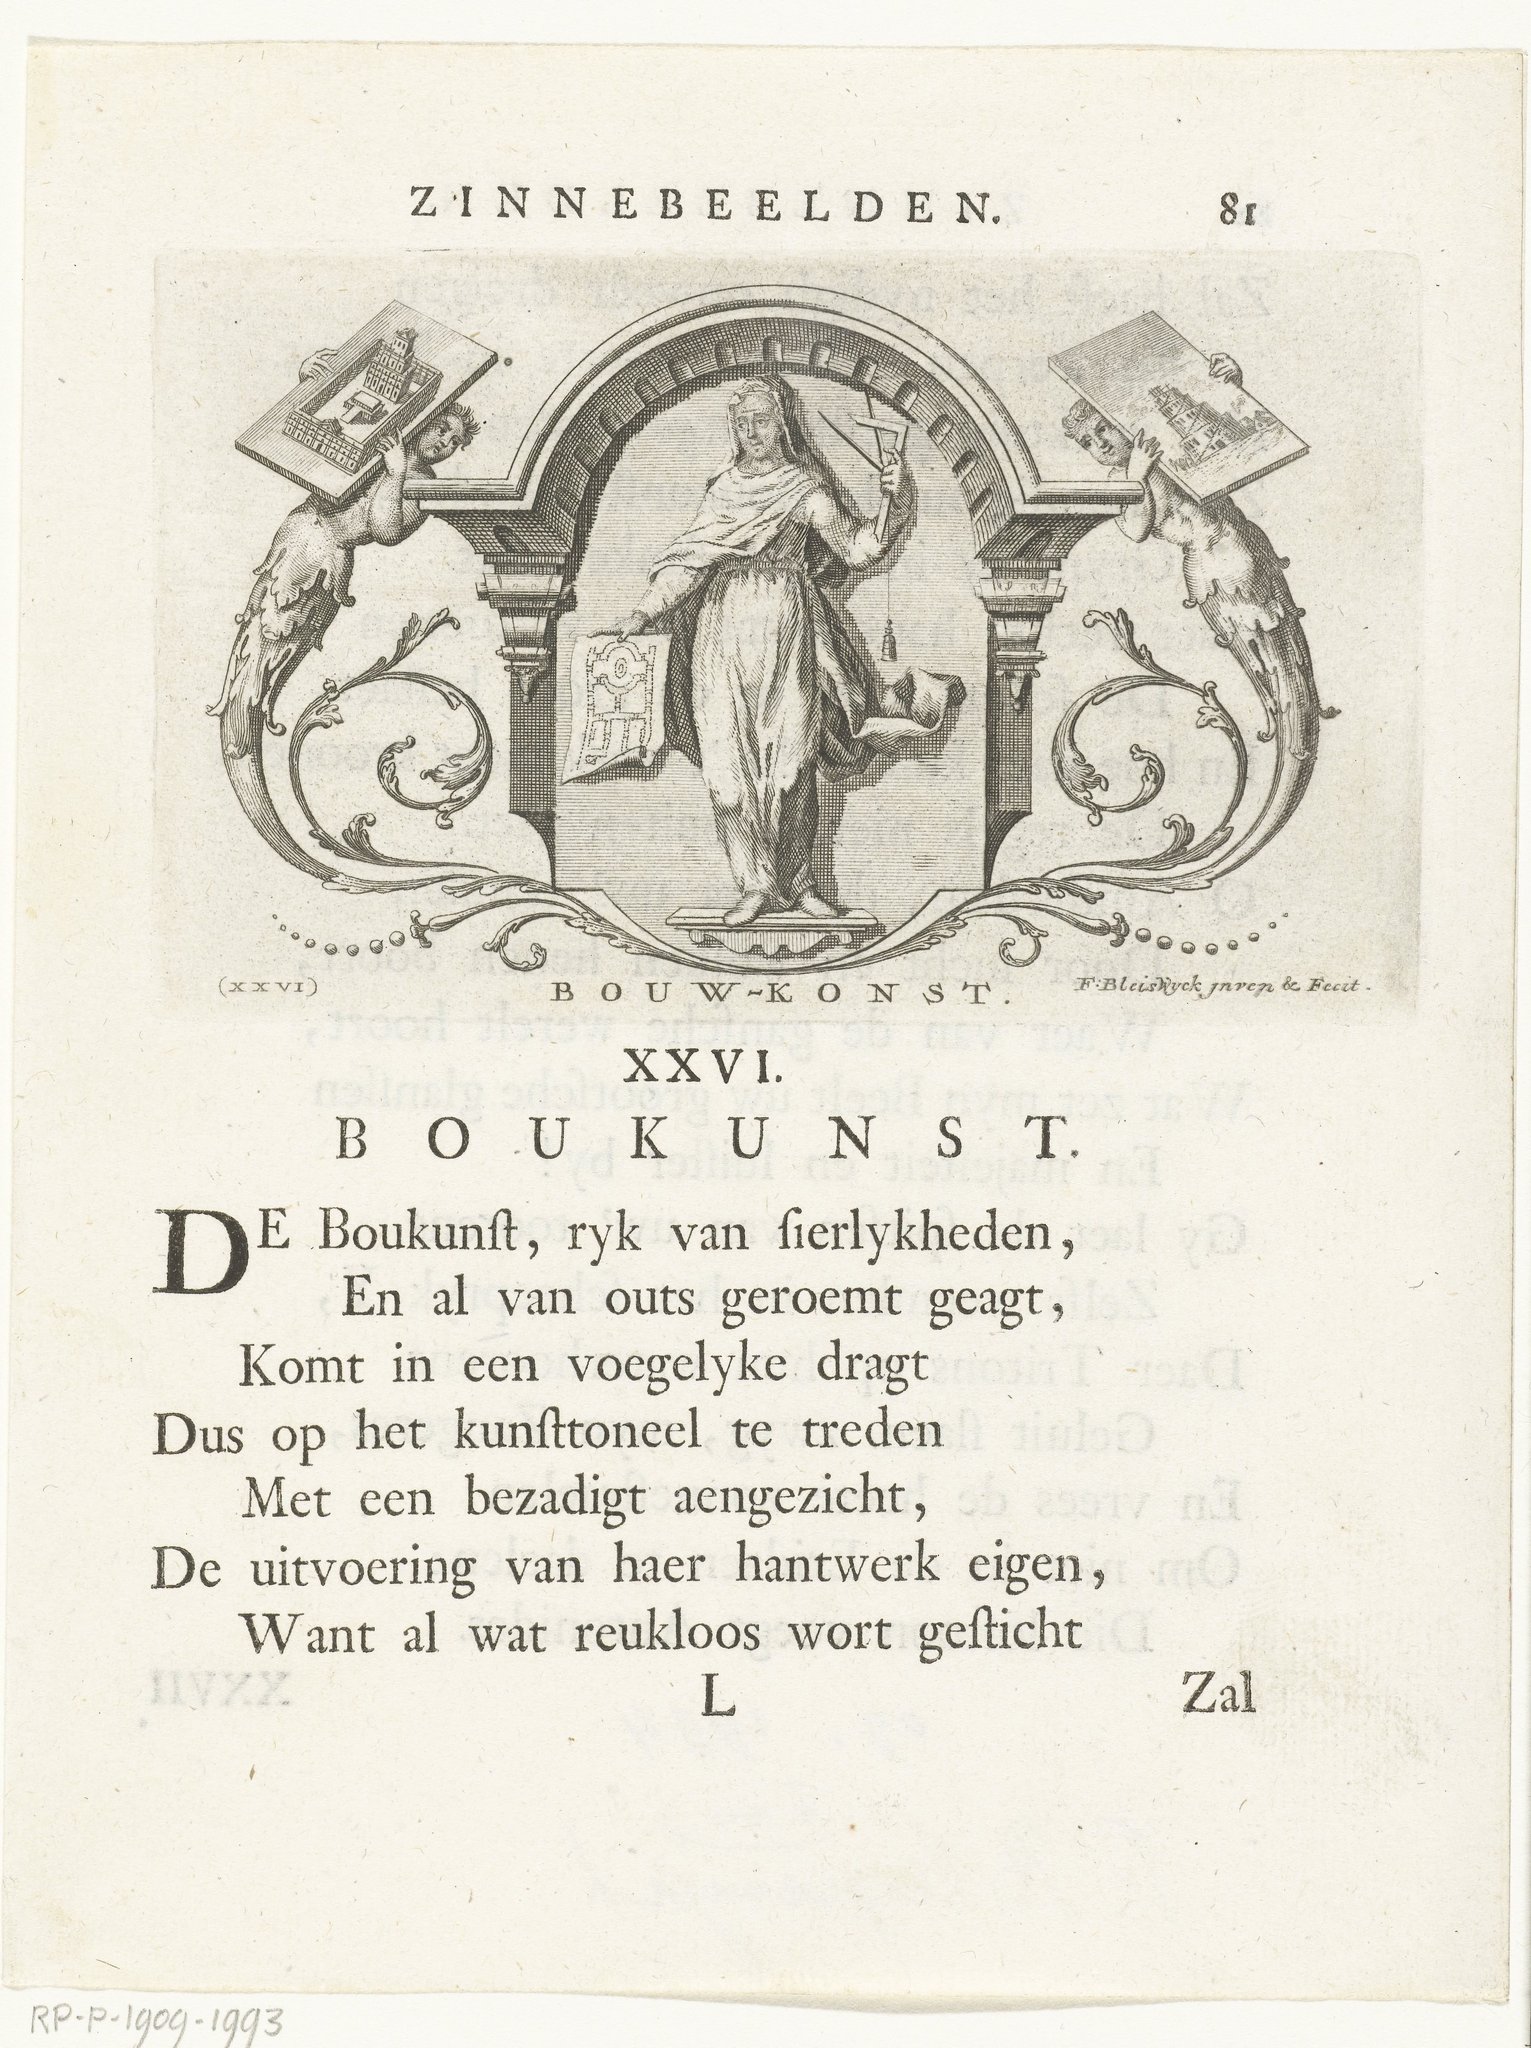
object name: book illustration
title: Bouw-konst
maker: françois van bleyswijck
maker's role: draughtsman, print maker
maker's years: 1671-1746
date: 1681-1737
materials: paper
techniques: etching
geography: leiden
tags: 'architectura', symbolic representations, allegories and emblems ~ architecture; 'architettura' (ripa)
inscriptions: collector's mark: Lugt 2228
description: Embleem met allegorie op bouwkunst verbeeld als vrouw met winkelhaak, passer en bouwtekening staand in nis versierd met ornamenten. Het gekrulde bladwerk gaat over in twee jongens torso's die een beeltenis van de Toren van Babel en het Tabernakel vasthouden. Het gedicht op recto en verso eert de bouwkunst.